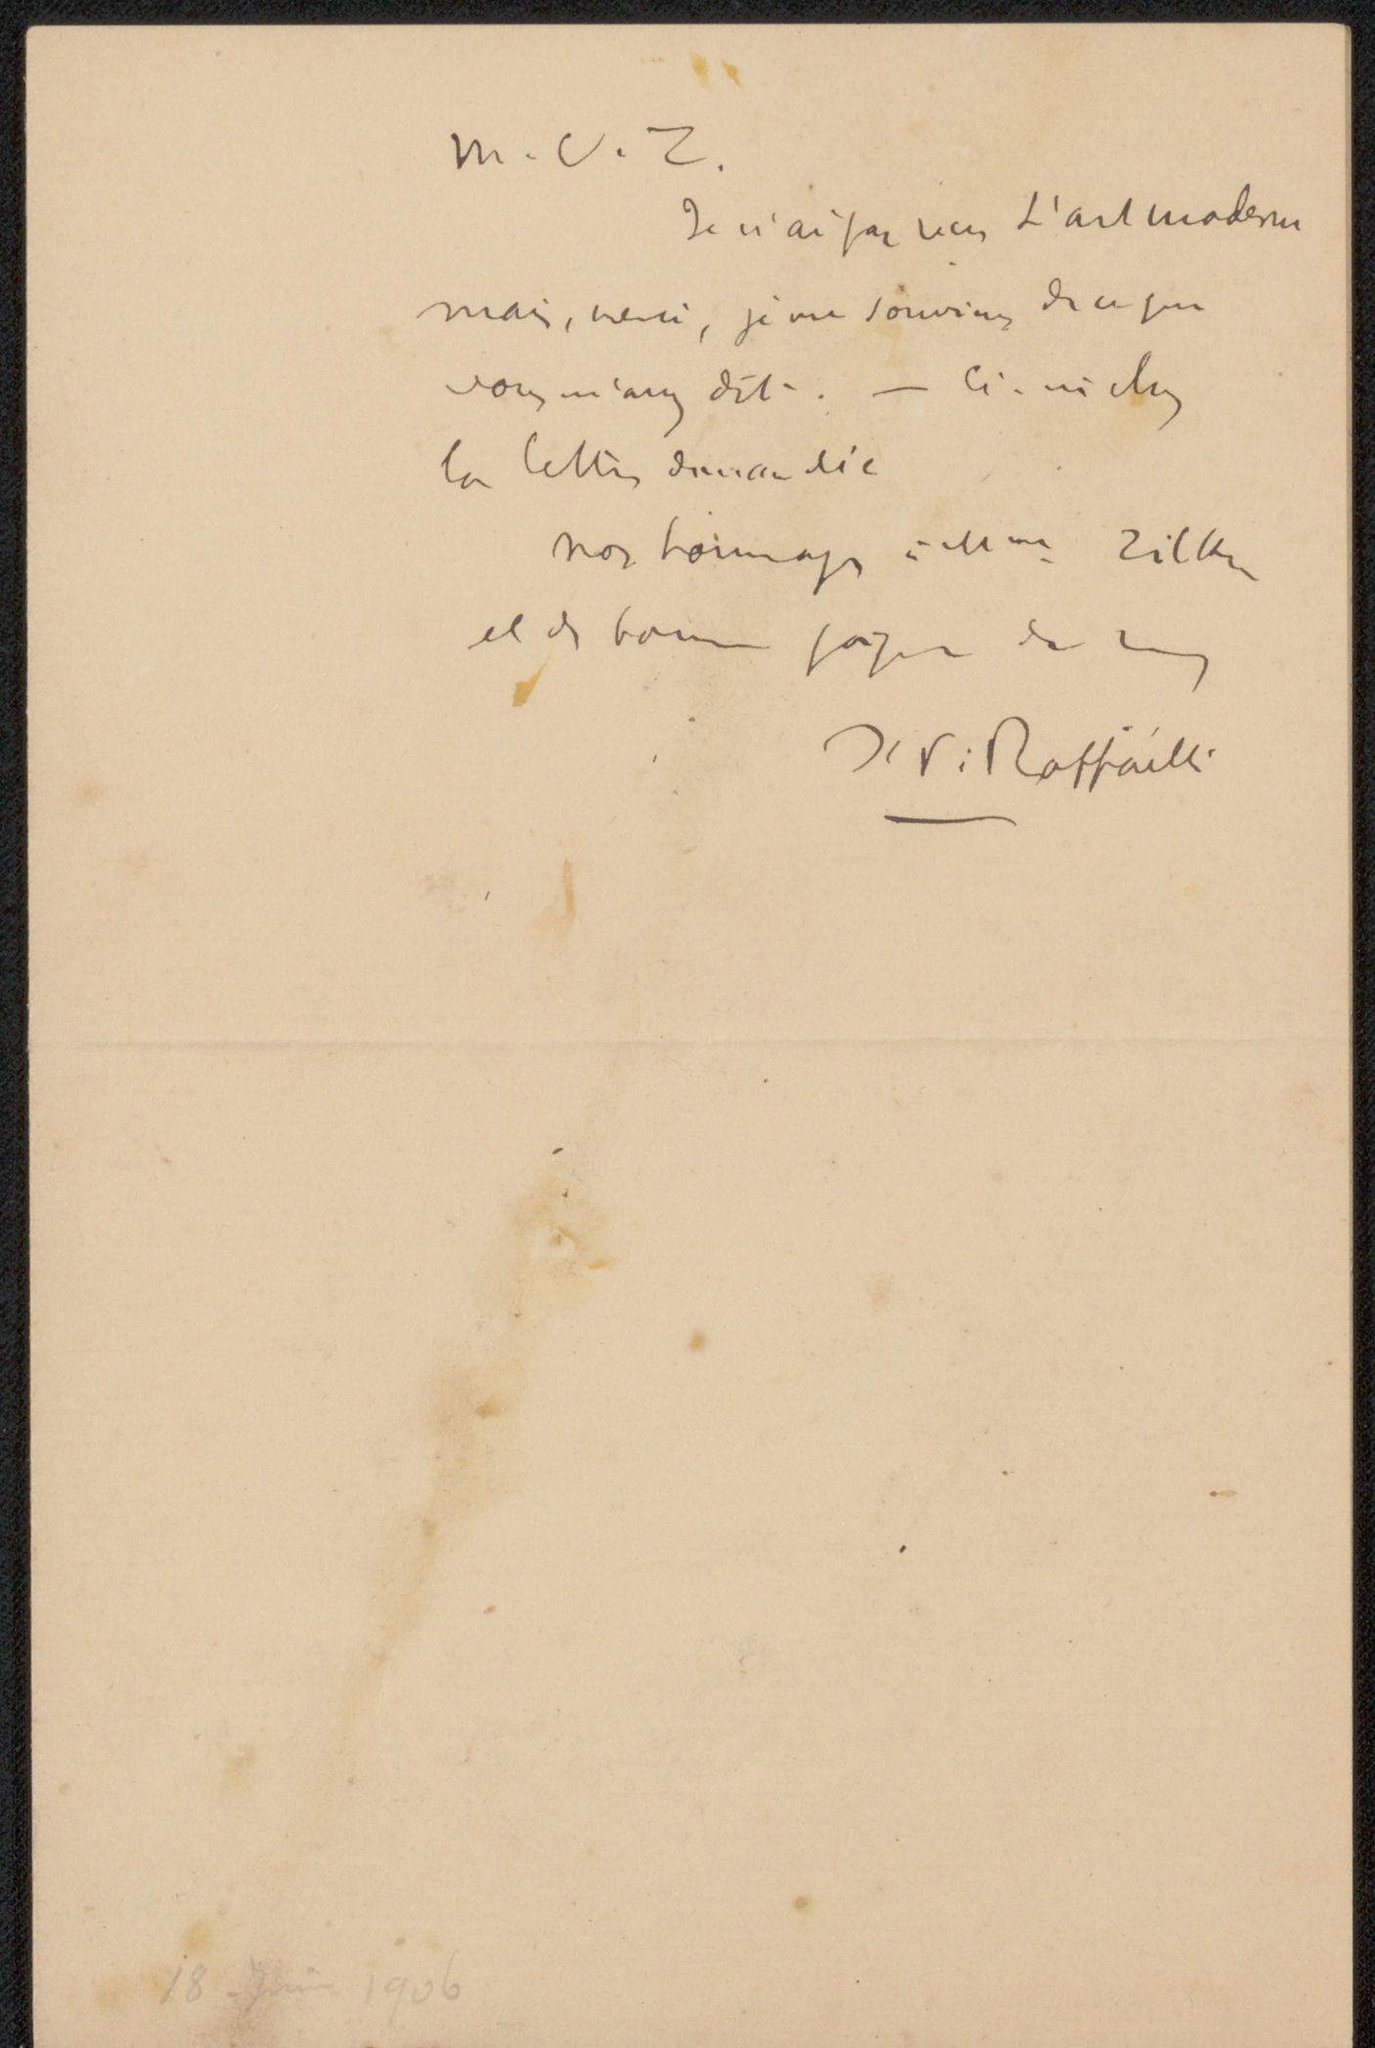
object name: letter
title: Brief aan Philip Zilcken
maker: jean françois raffaëlli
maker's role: print maker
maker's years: 1850-1924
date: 1905-1906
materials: ink, paper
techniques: pen, writing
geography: paris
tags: the hague, painter, draughtsman, philip zilcken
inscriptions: collector's mark: ‘RPK’